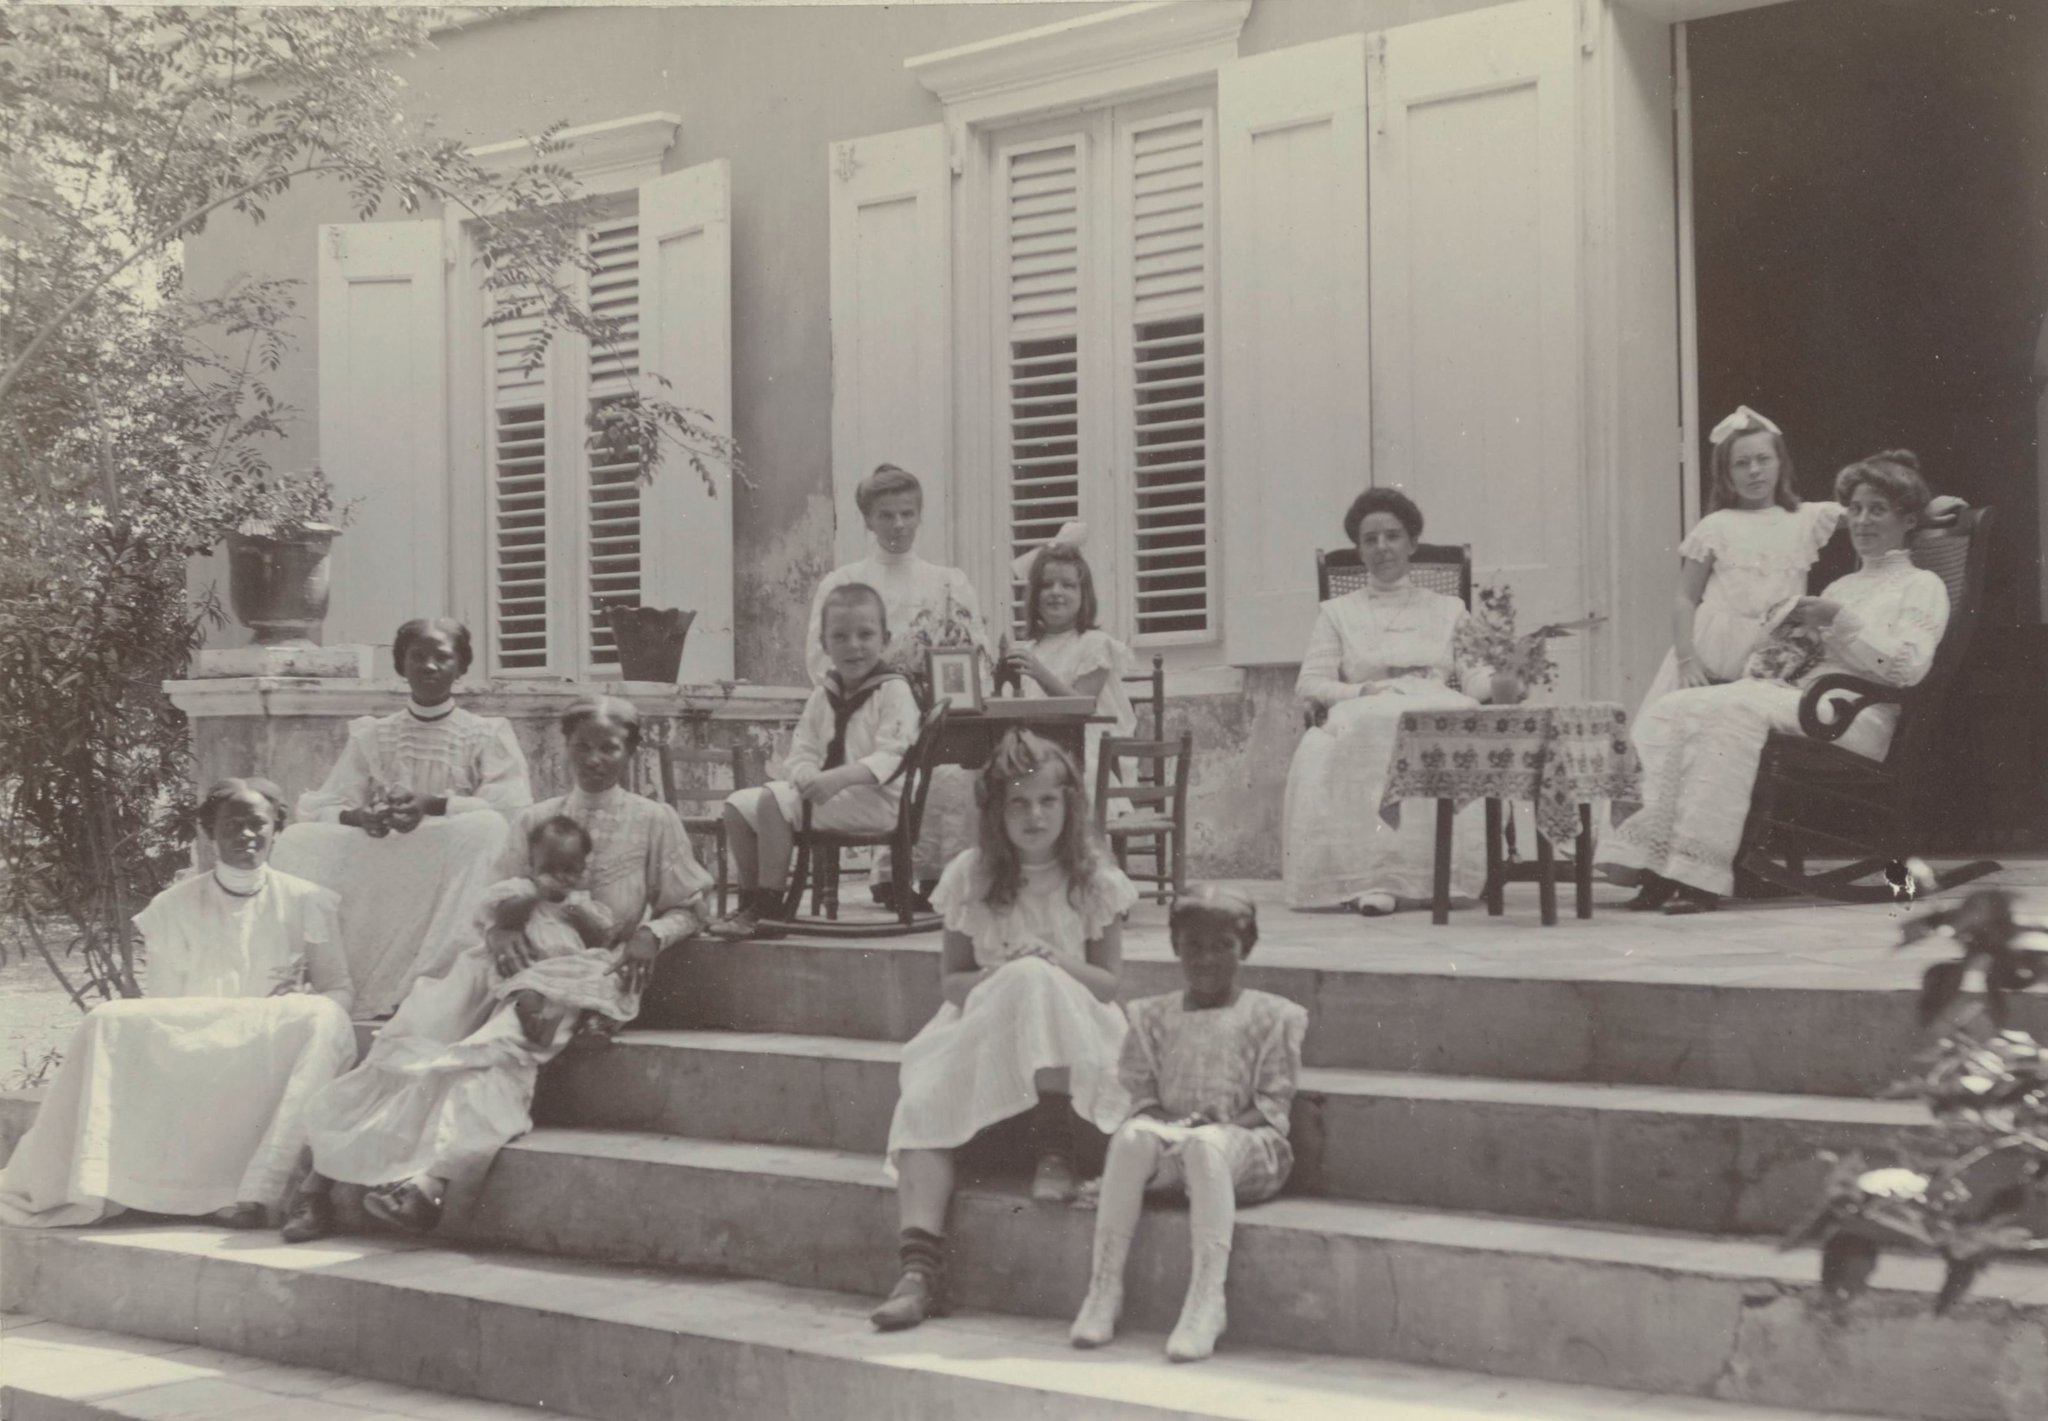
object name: photograph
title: Op Plantage Roosendaal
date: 1906-1910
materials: photographic support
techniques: photography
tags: plantation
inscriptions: inscription: ‘Koenoekoe "Roosendaal", Curaçao 1910. Familie Fock en ...’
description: Groepsfoto van de Europese vrouwen en kinderen met Curaçaos personeel op Plantage (Koenoekoe) Roosendaal, op Curaçao, juni 1910. Onderdeel van het fotoalbum van de familie Boom-Gonggrijp in Suriname en Curaçao.